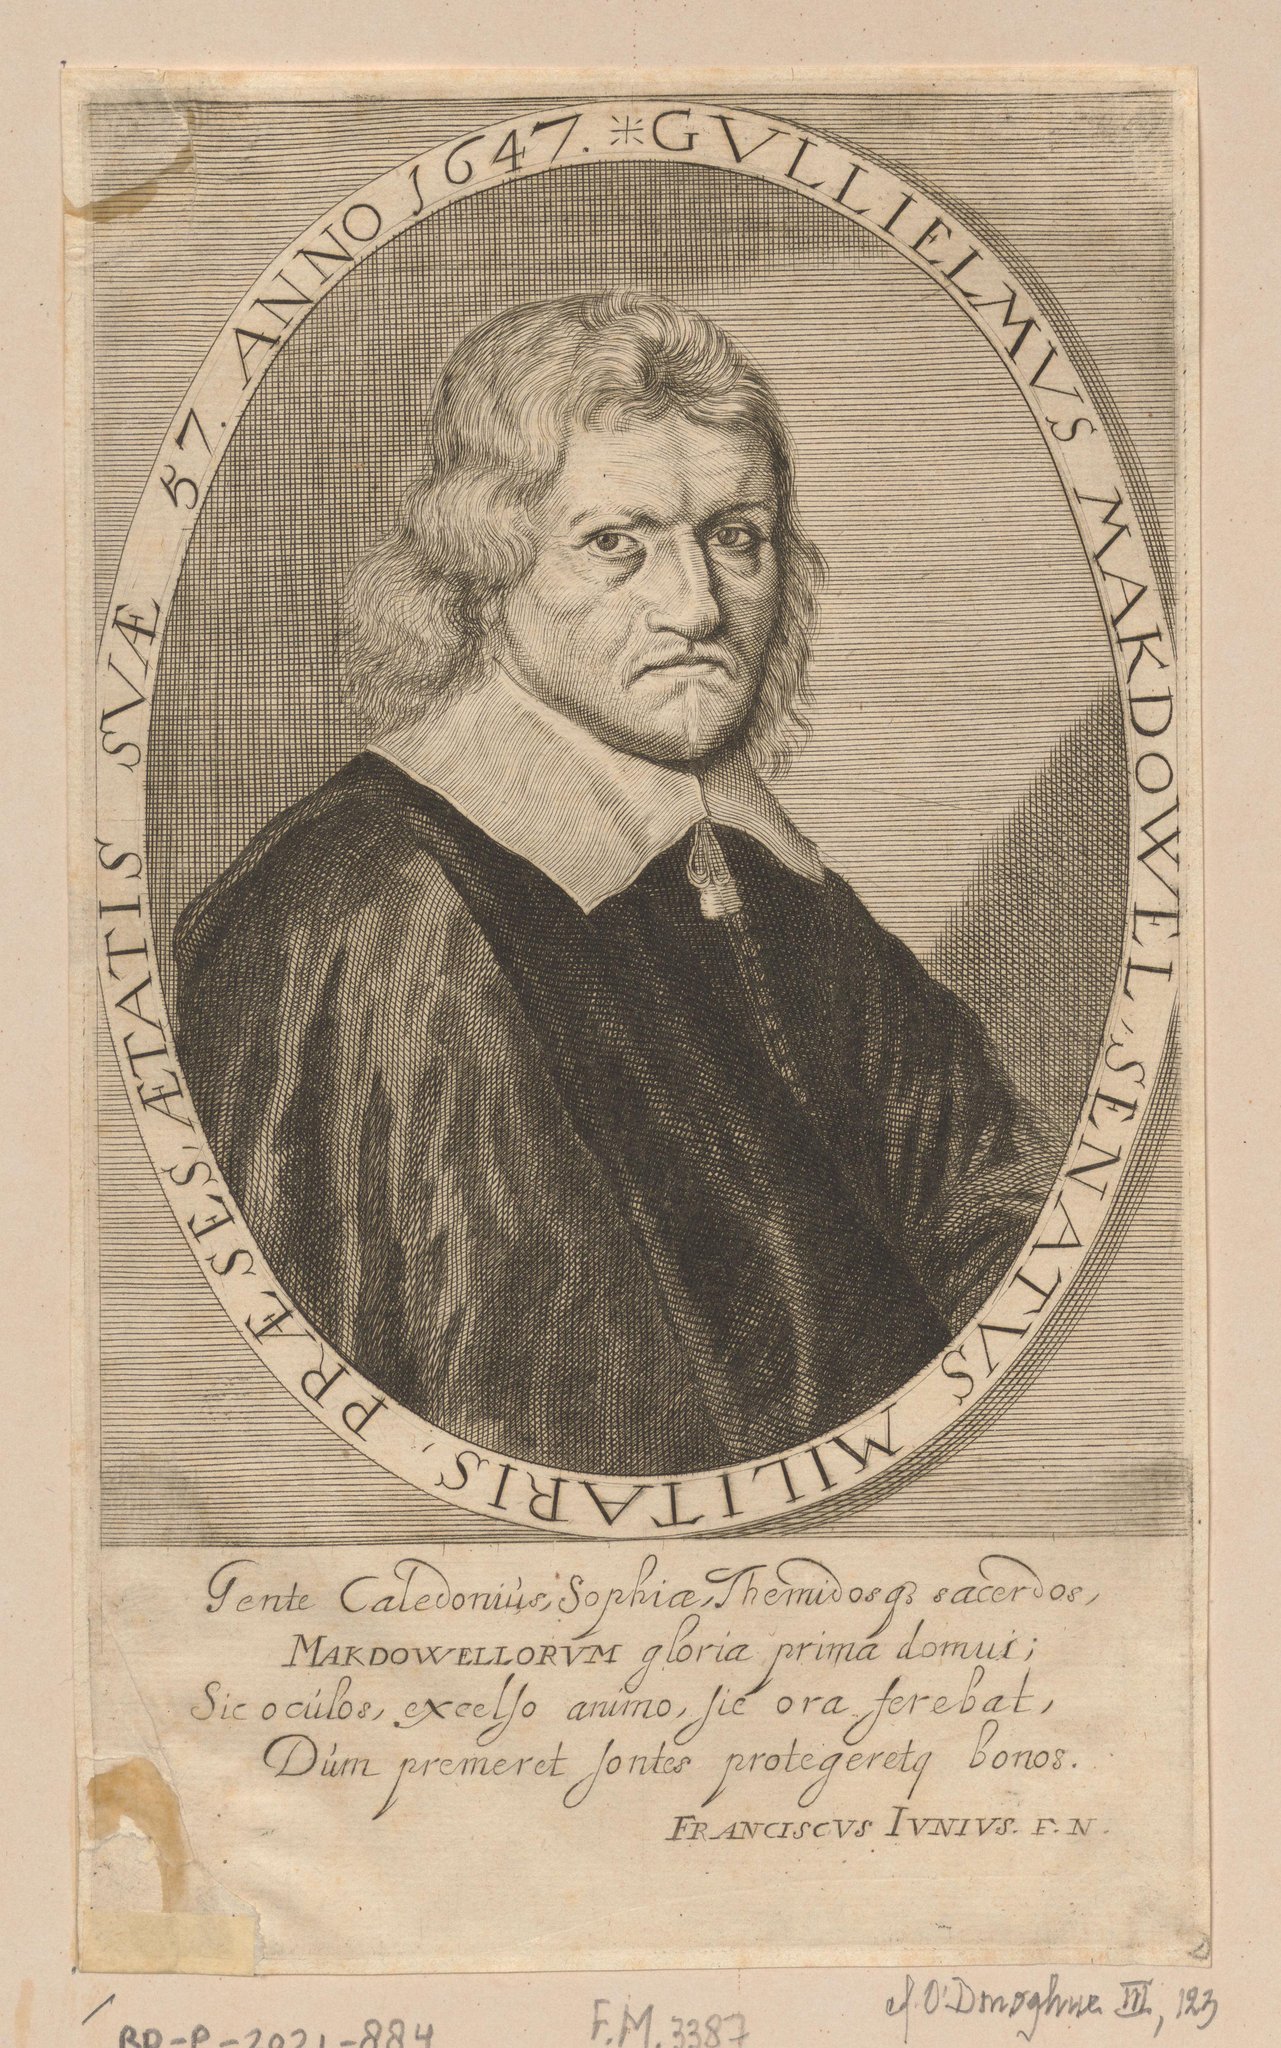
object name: book illustration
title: Portret van William Makdowell op 57-jarige leeftijd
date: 1654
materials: paper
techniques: engraving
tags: historical persons, professor, scholar, philosopher (+ portrait of scholar, scientist)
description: Prent waarschijnlijk uit: Effigies & vitae Professorvm Academiae Groningae & Omlandiae. Groningen: Jan Claessen, 1654.